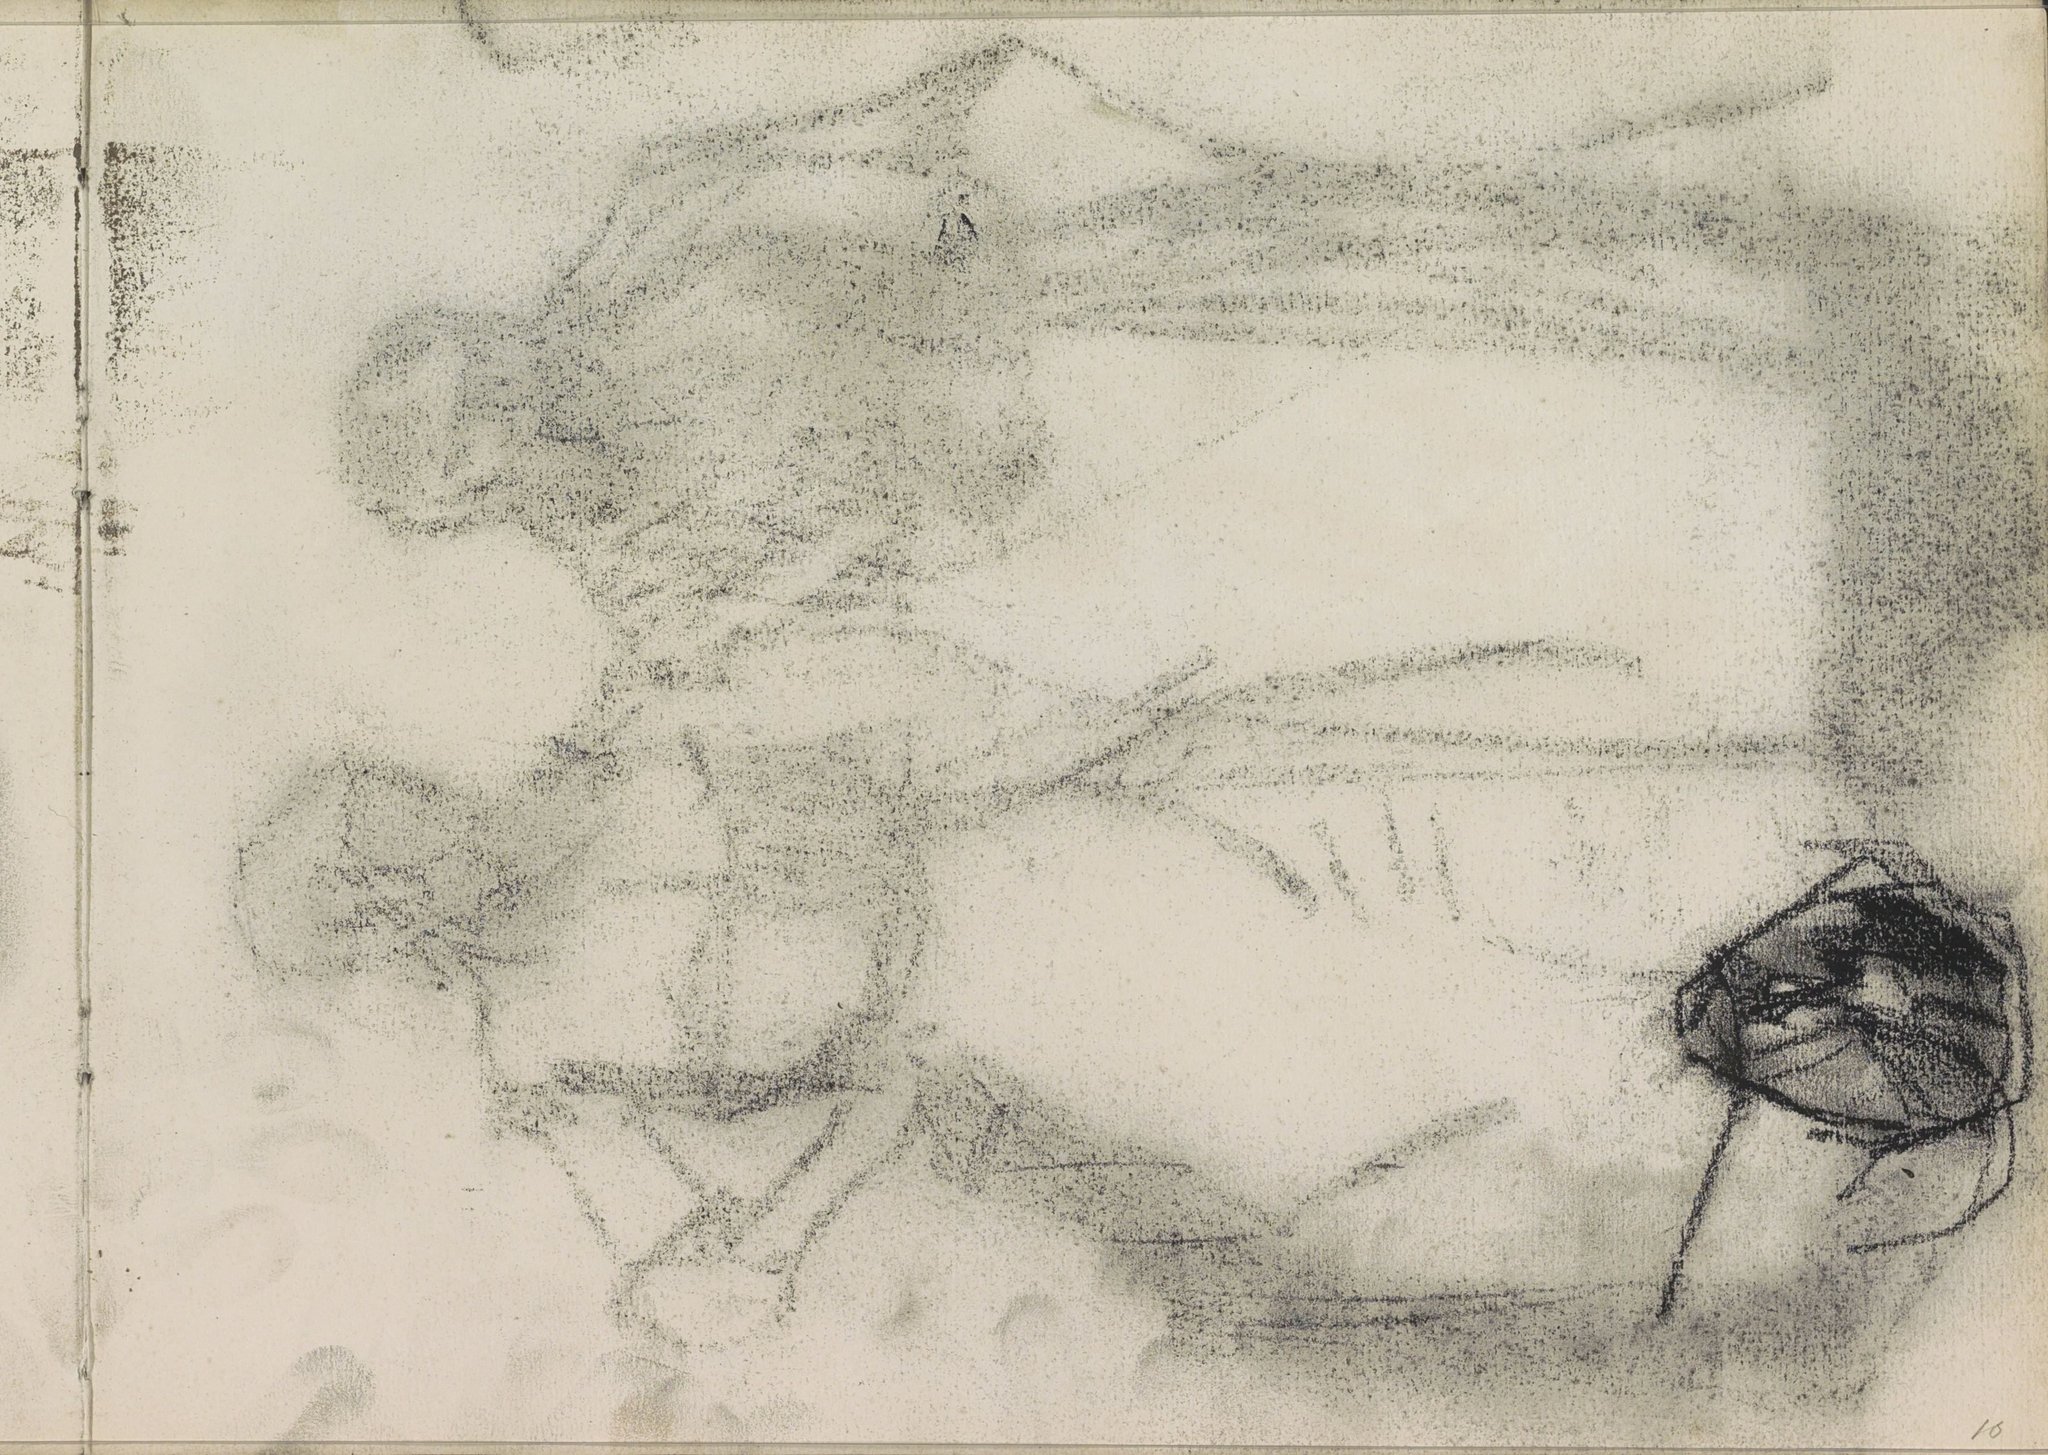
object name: sketchbook leaf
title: Hoofd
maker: isaac israels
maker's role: draughtsman, painter, print maker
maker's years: 1865-1934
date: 1892-1900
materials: chalk, paper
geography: the hague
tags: head (human)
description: Blad 10 recto uit schetsboek VIII met 12 bladen.